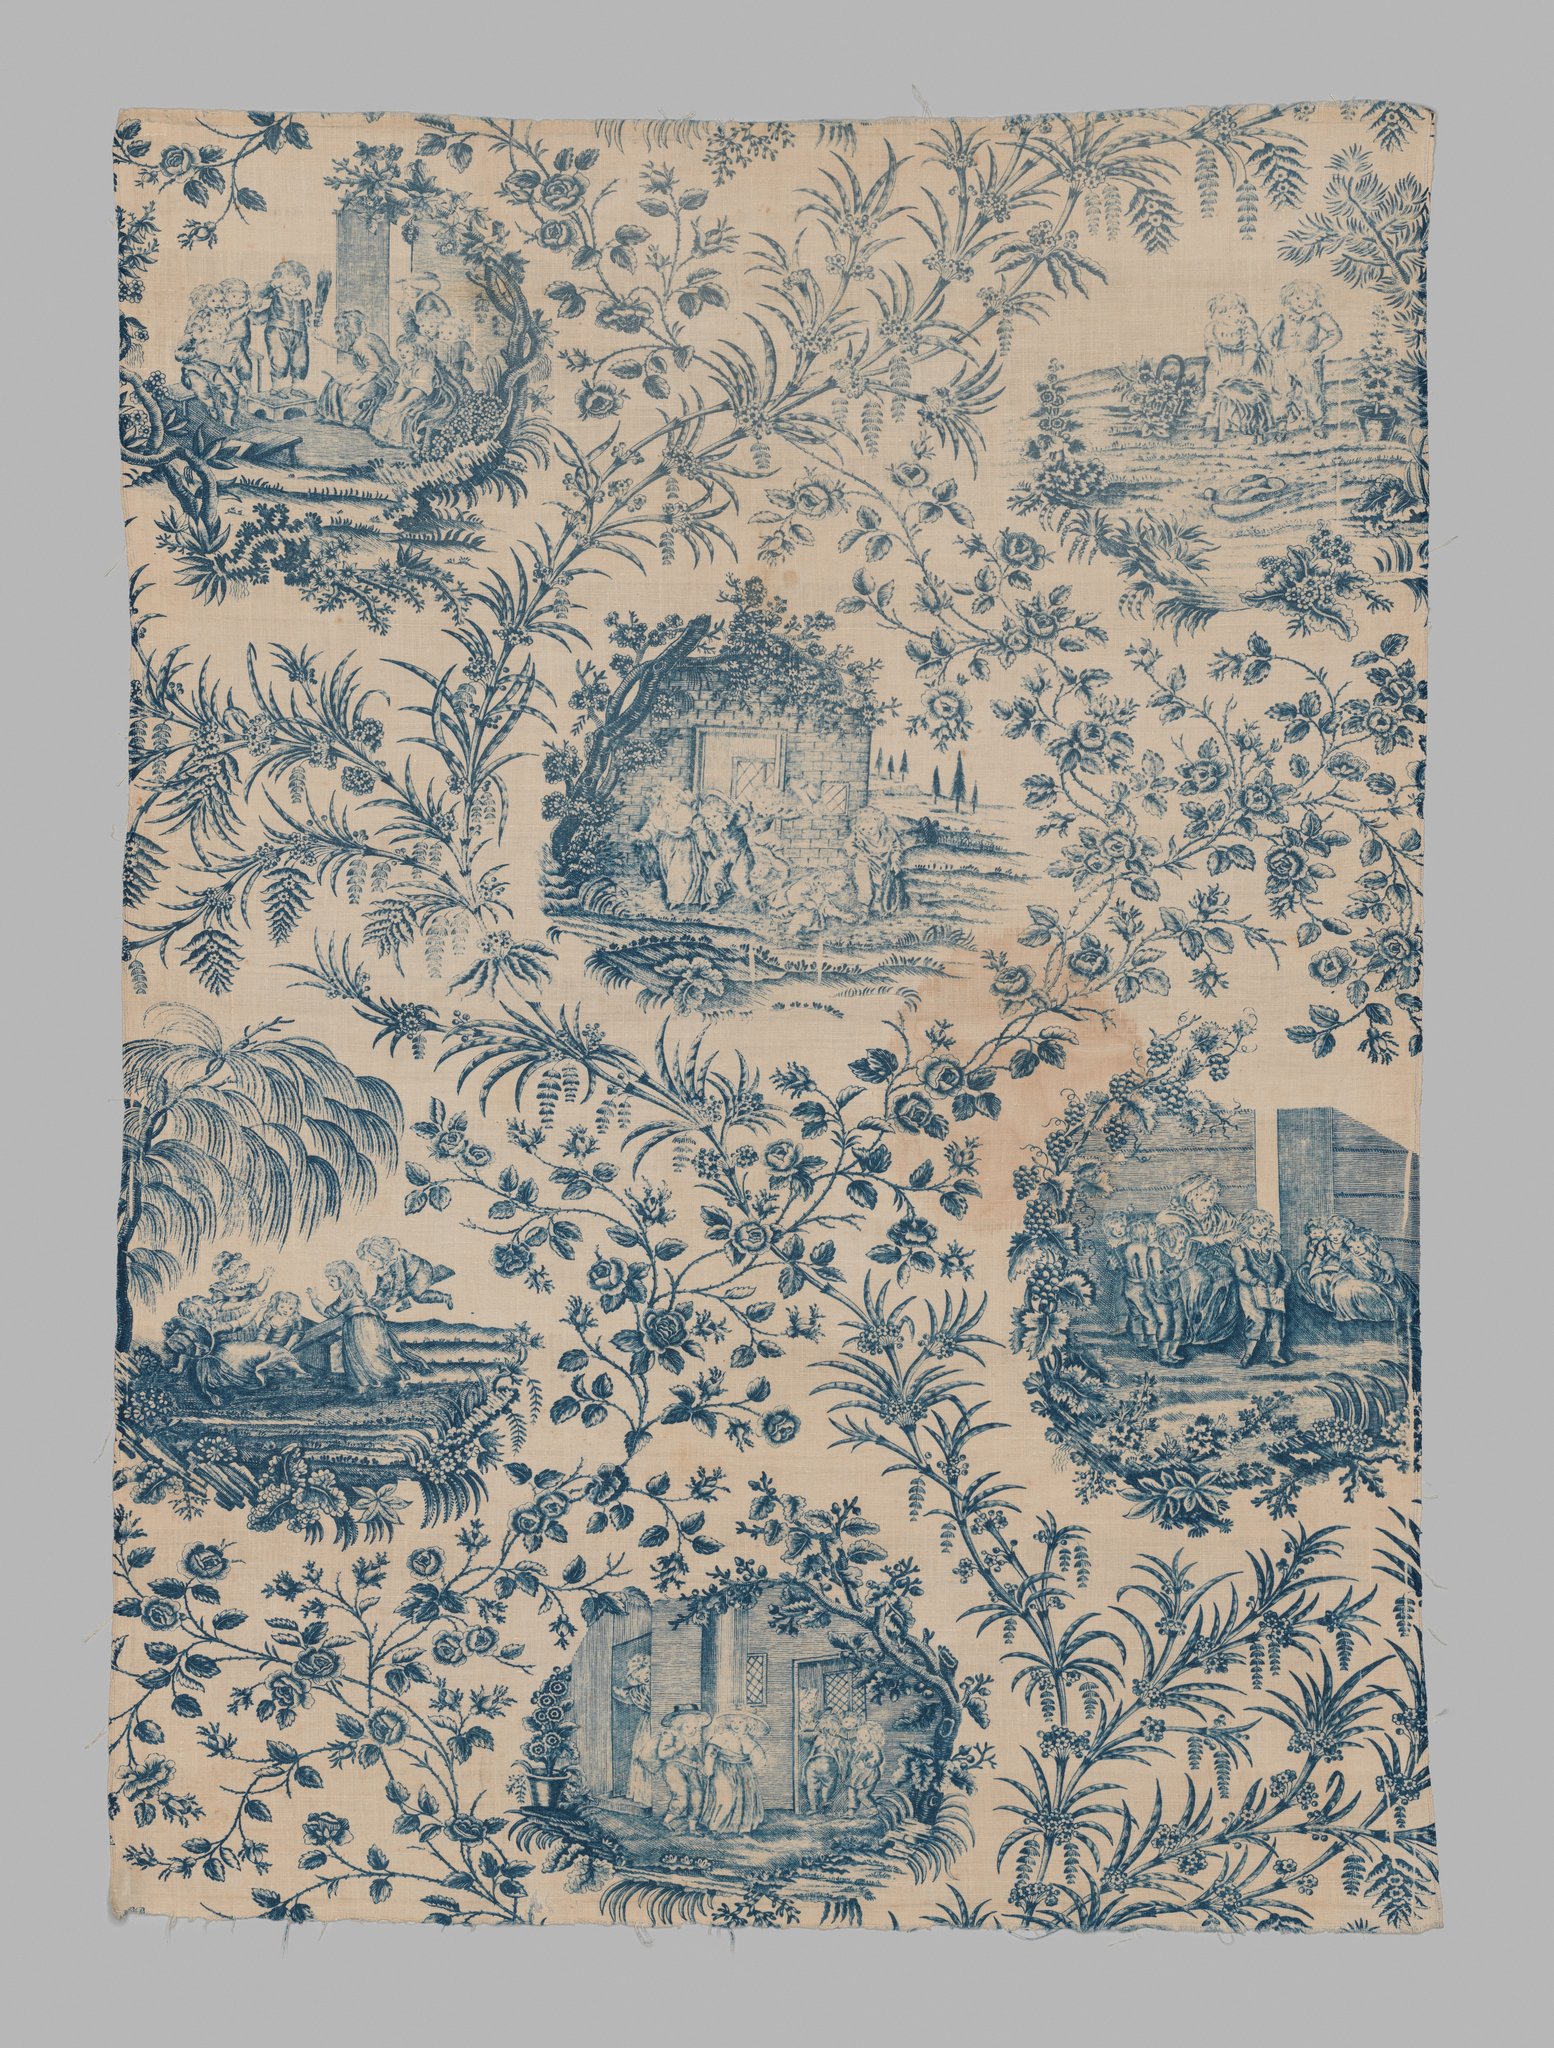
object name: furnishing textile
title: Pictorial print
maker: bromley hall printworks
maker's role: manufactory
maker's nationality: english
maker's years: 1694-1823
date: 1790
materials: cotton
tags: children,women